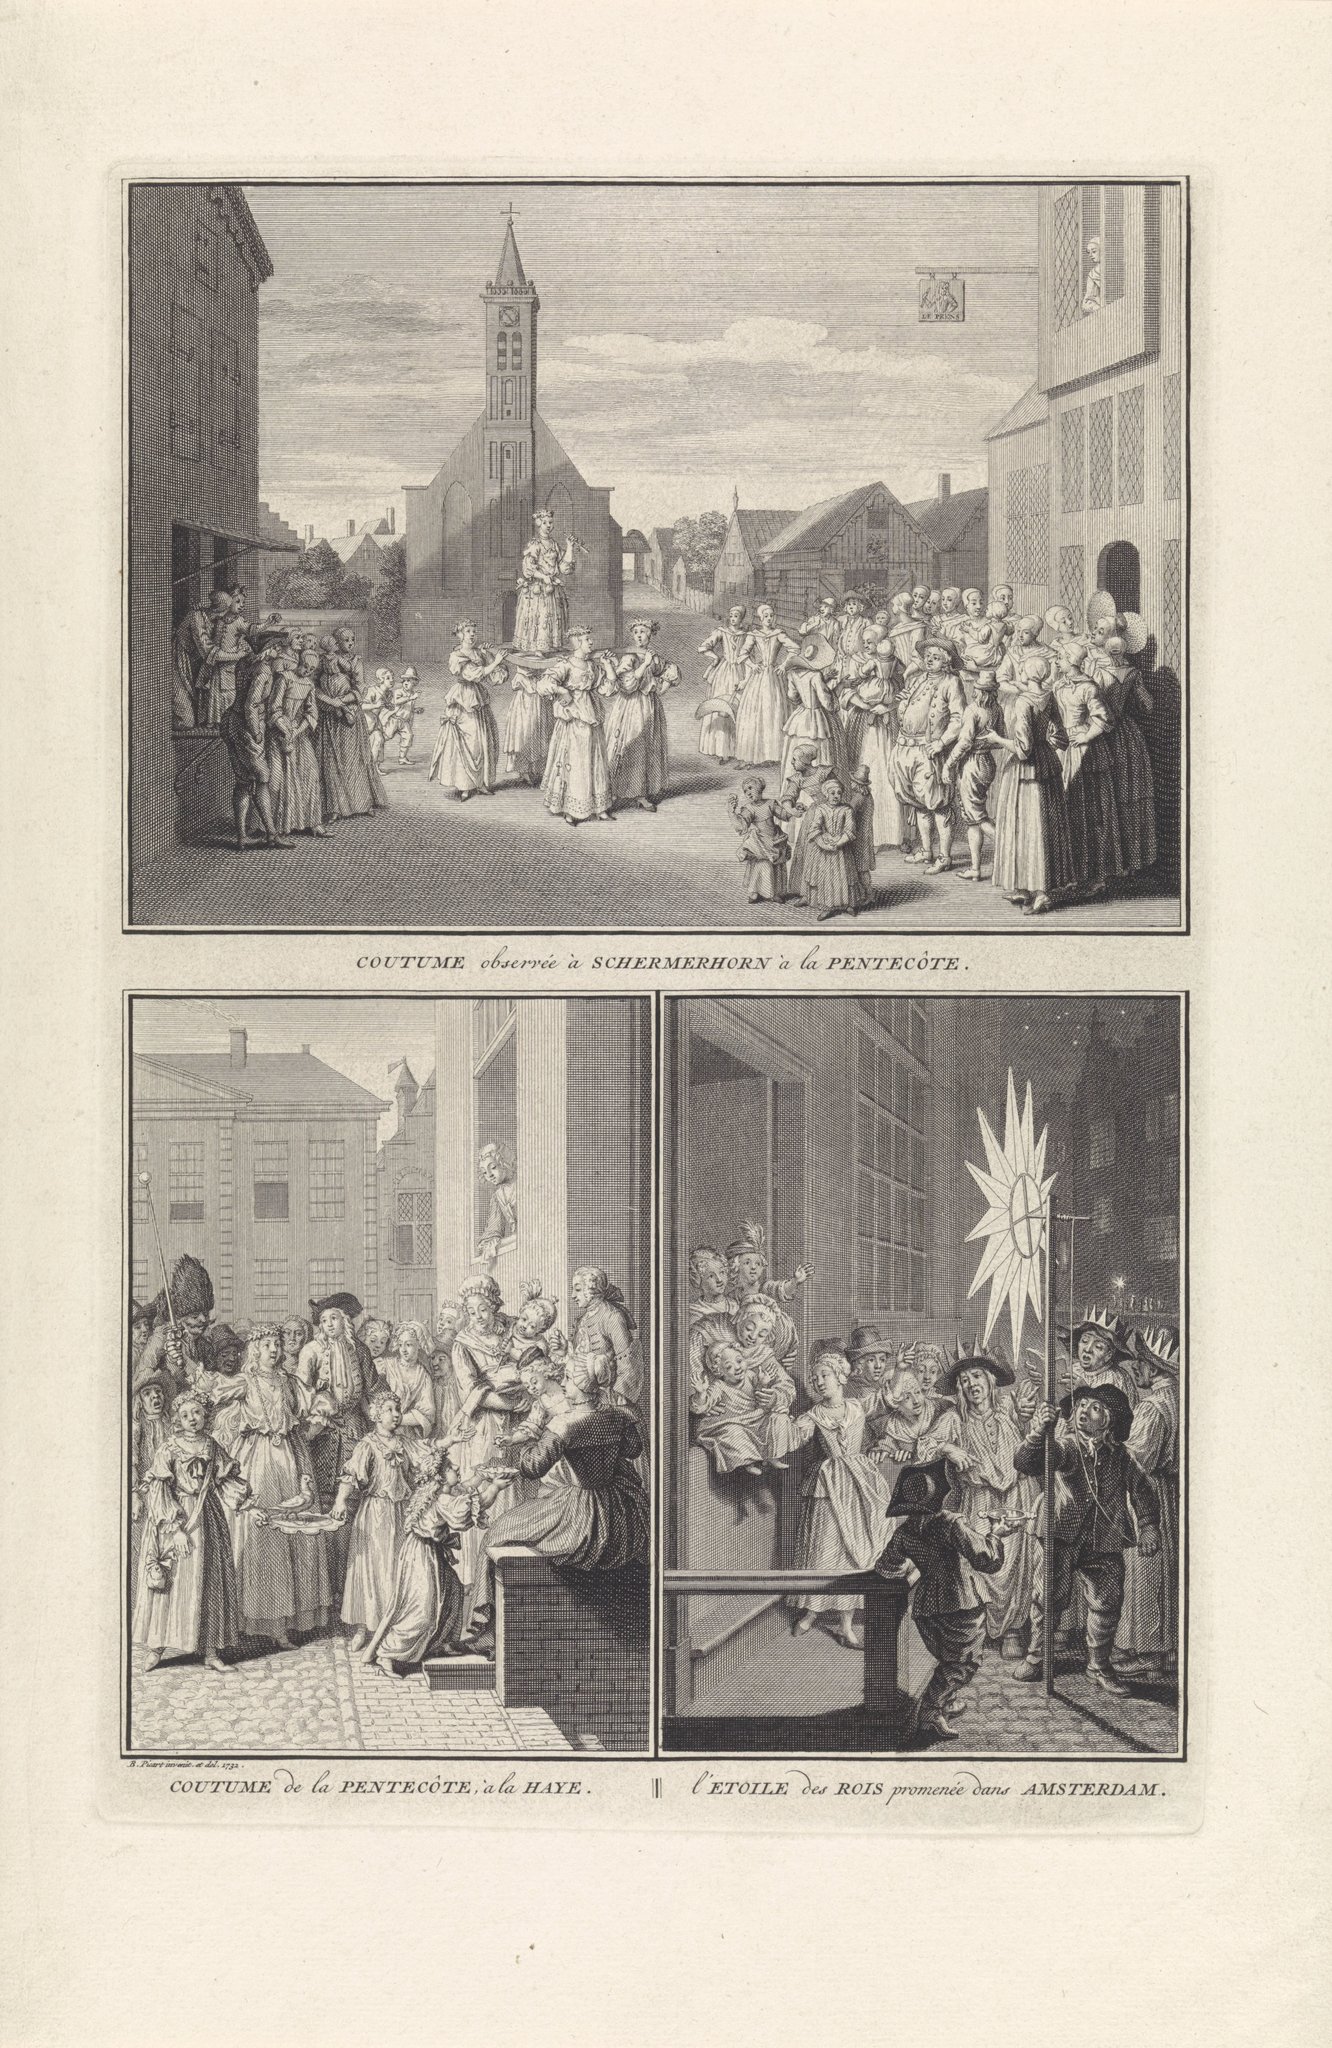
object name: print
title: Coutume observée à Schermerhorn à la Pentecôte / Coutume de la Pentecôte, à La Haye / l'Etoille des Rois promenée dans Amsterdam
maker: bernard picart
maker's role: draughtsman, print maker, publisher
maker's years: 1673-1733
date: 1732-1736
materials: paper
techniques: engraving, etching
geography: amsterdam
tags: pentecost, whitsunday, epiphany, the hague, amsterdam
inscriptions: collector's mark: Lugt 240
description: Prent ook gebruikt in: Picart, Bernard. Ceremonies et coutumes religieuses de tous les peuples du monde (...). 10 delen. Amsterdam: Jean Frederic Bernard, 1723-1743, deel 3 (1733), na p. 352. En in de Nederlandse vertaling: Picart, Bernard en Abraham Moubach. Naaukeurige beschryving der uitwendige godtsdienst-plichten, kerk-zeden en gewoontens van alle volkeren der waereldt : in een historisch verhaal (...). 6 delen. 's-Gravenhage: Rutgert Christoffel Alberts, 1727-1738, deel 5 (1736), na p. 326.